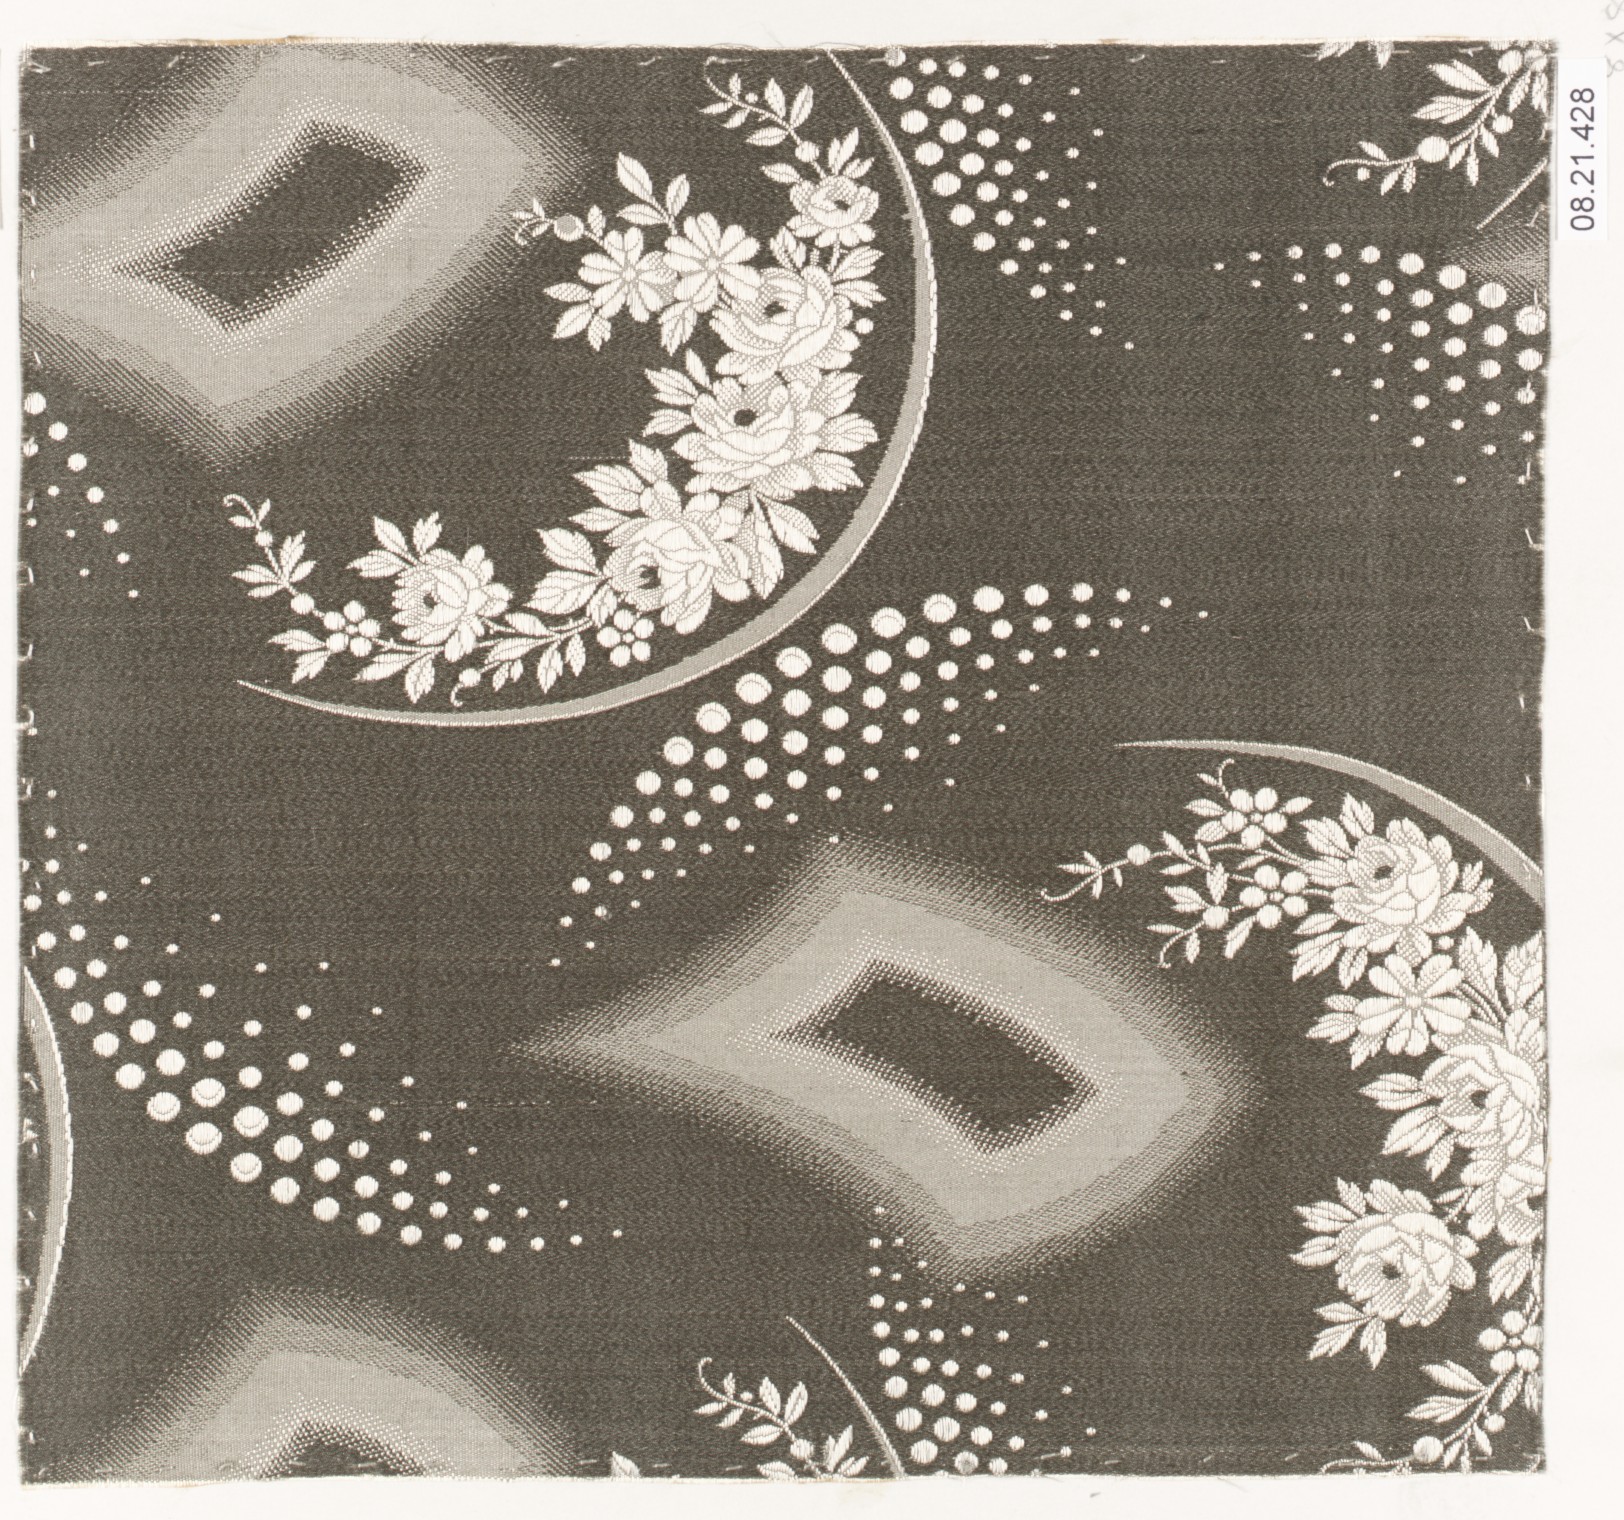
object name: textile sample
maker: Anonymous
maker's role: designer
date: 1900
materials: silk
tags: flowers